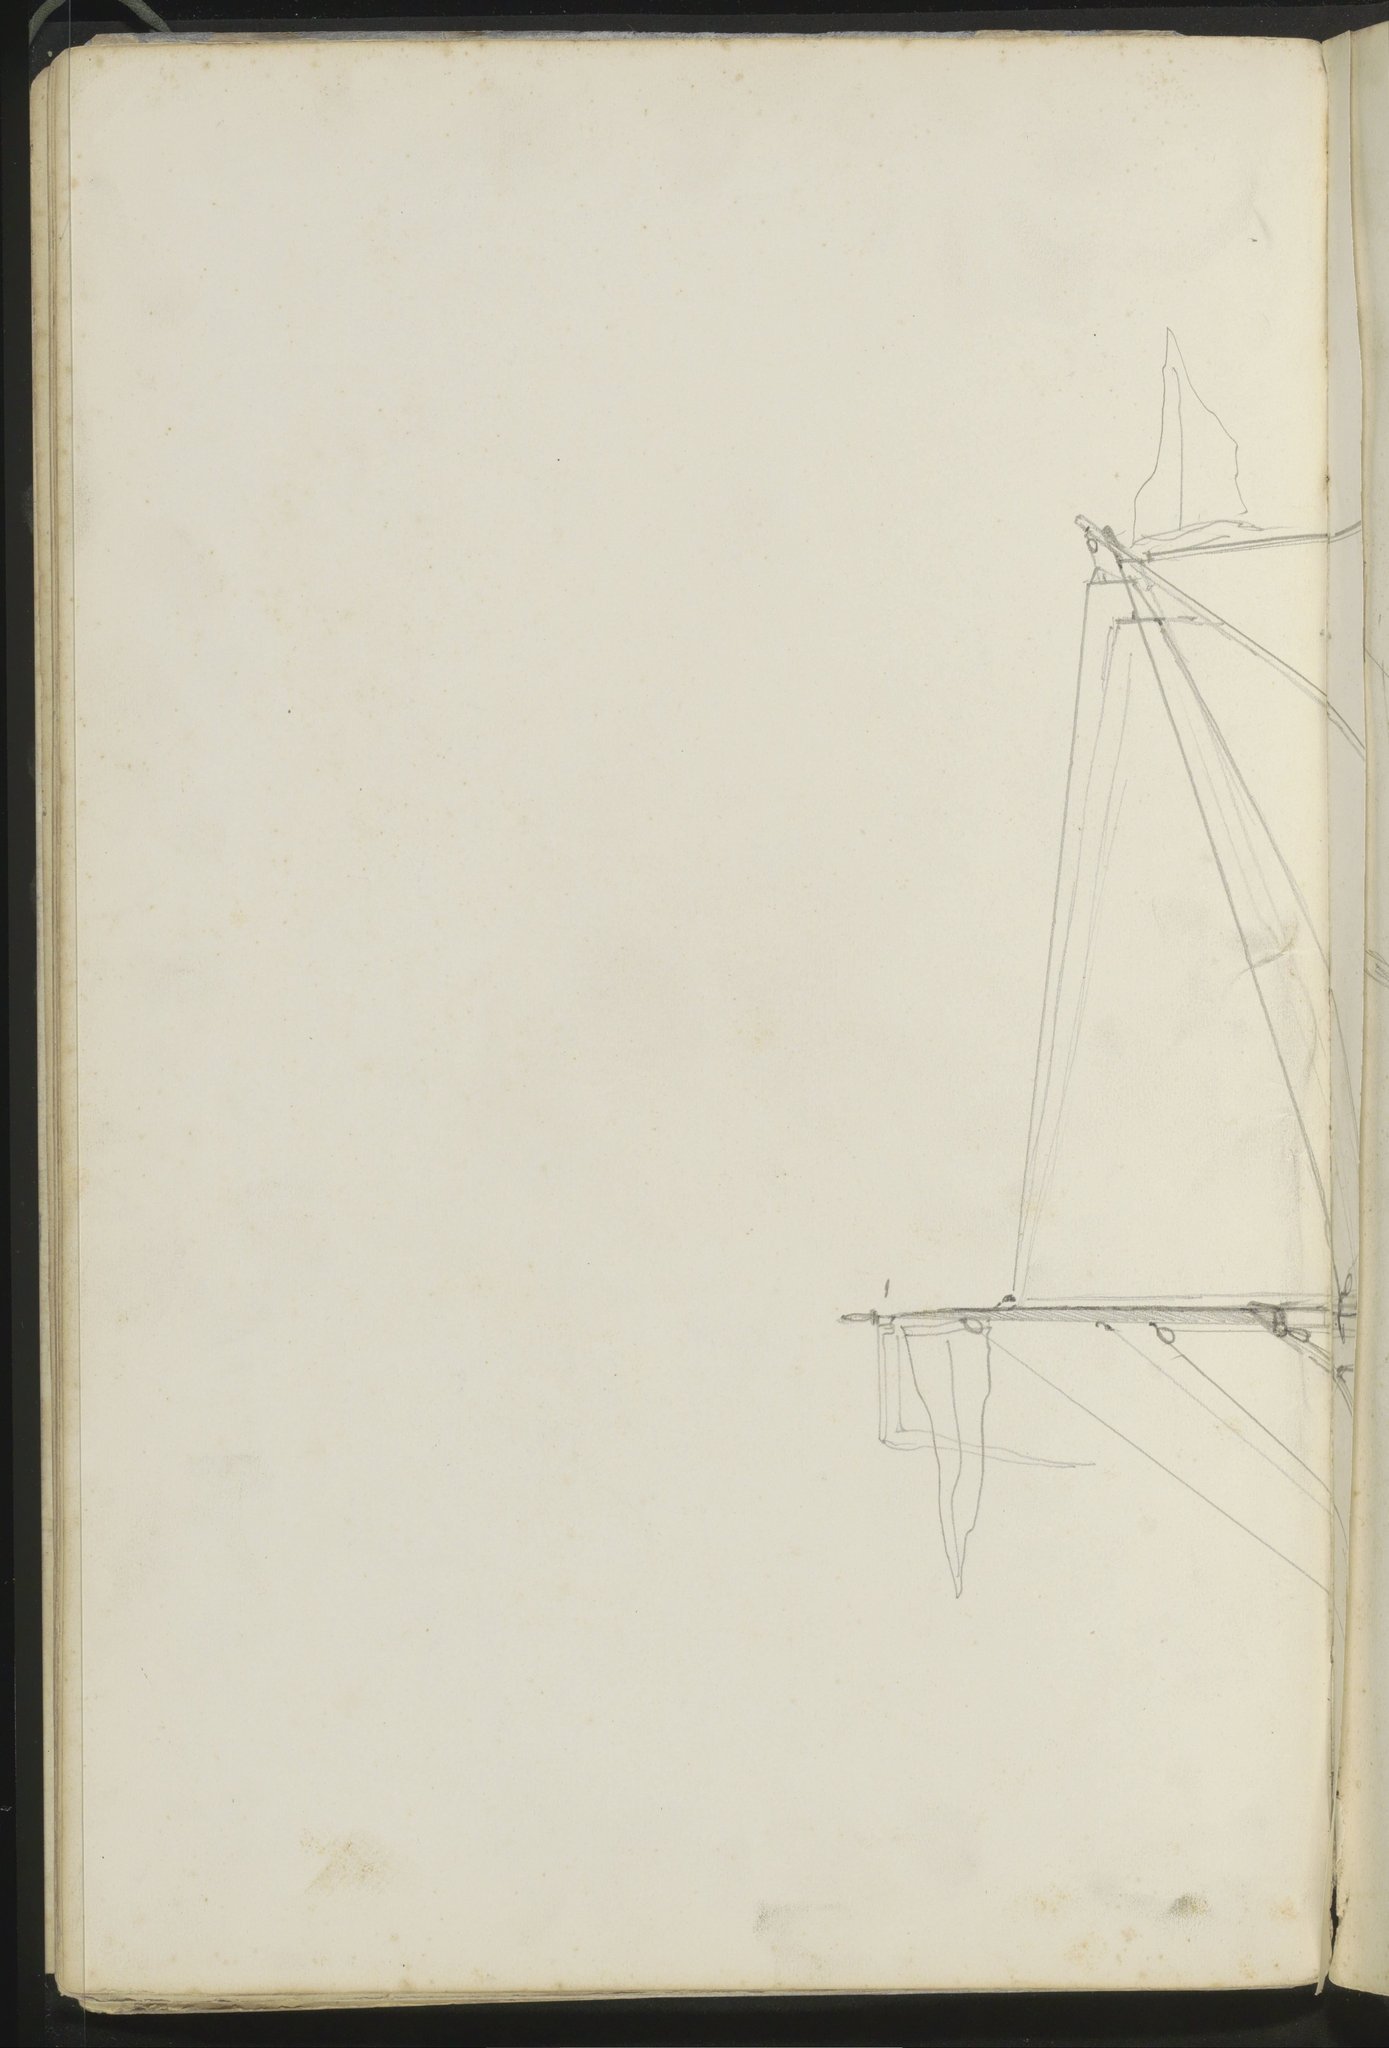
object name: sketchbook leaf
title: Zeilschip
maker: willem koekkoek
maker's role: draughtsman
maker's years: 1839-1895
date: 1849-1895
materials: paper, pencil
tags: sailing-ship, sailing-boat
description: Blad 13 verso en 14 recto uit een schetsboek met 35 bladen.